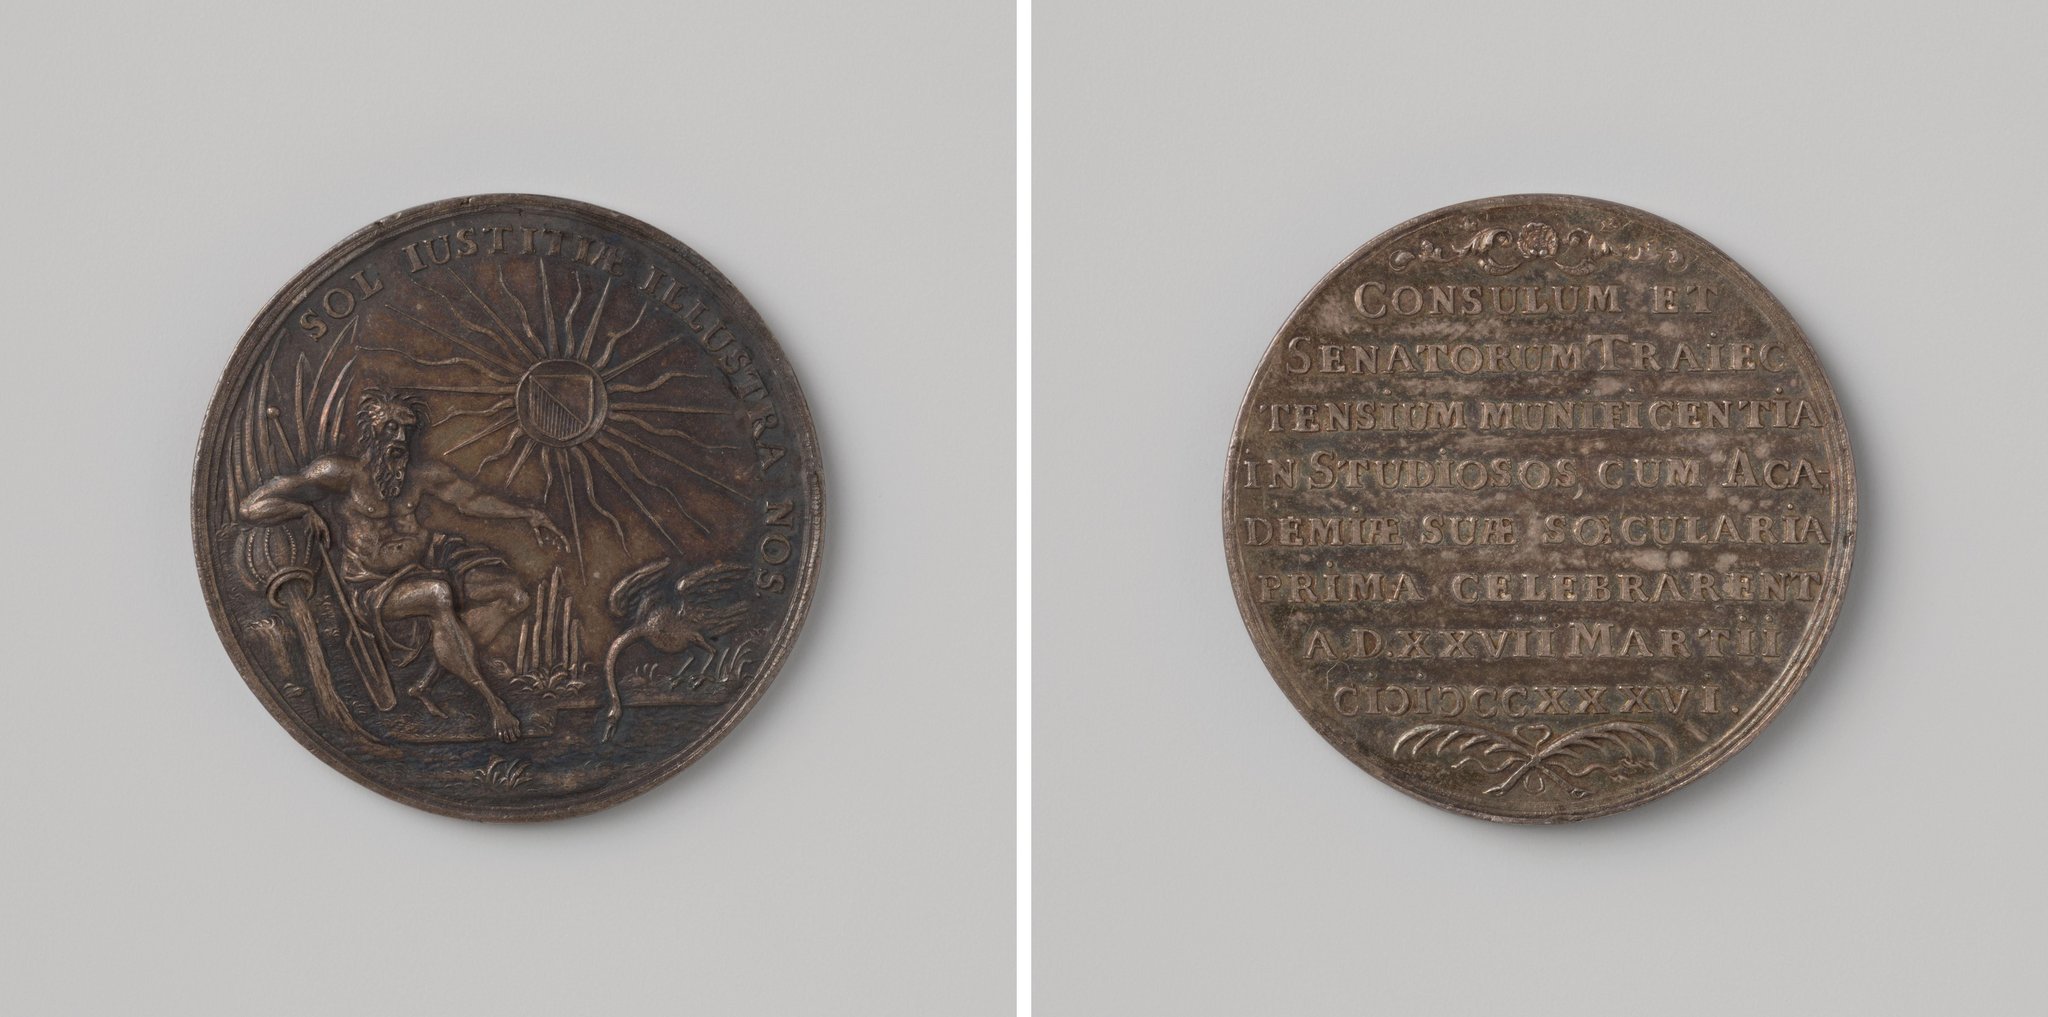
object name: history medal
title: Eeuwfeest van de Hogeschool te Utrecht, vereerd aan de studenten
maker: cornelis van swinderen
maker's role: medailleur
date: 1736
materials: silver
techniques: striking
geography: utrecht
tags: utrecht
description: Zilveren penning. Voorzijde: zittende riviergod met spaan en kruik, aan zijn voeten eendje die uit rivier drinkt beschenen door een wapenschild in een stralenkrans binnen omschrift. Keerzijde: opschrift.